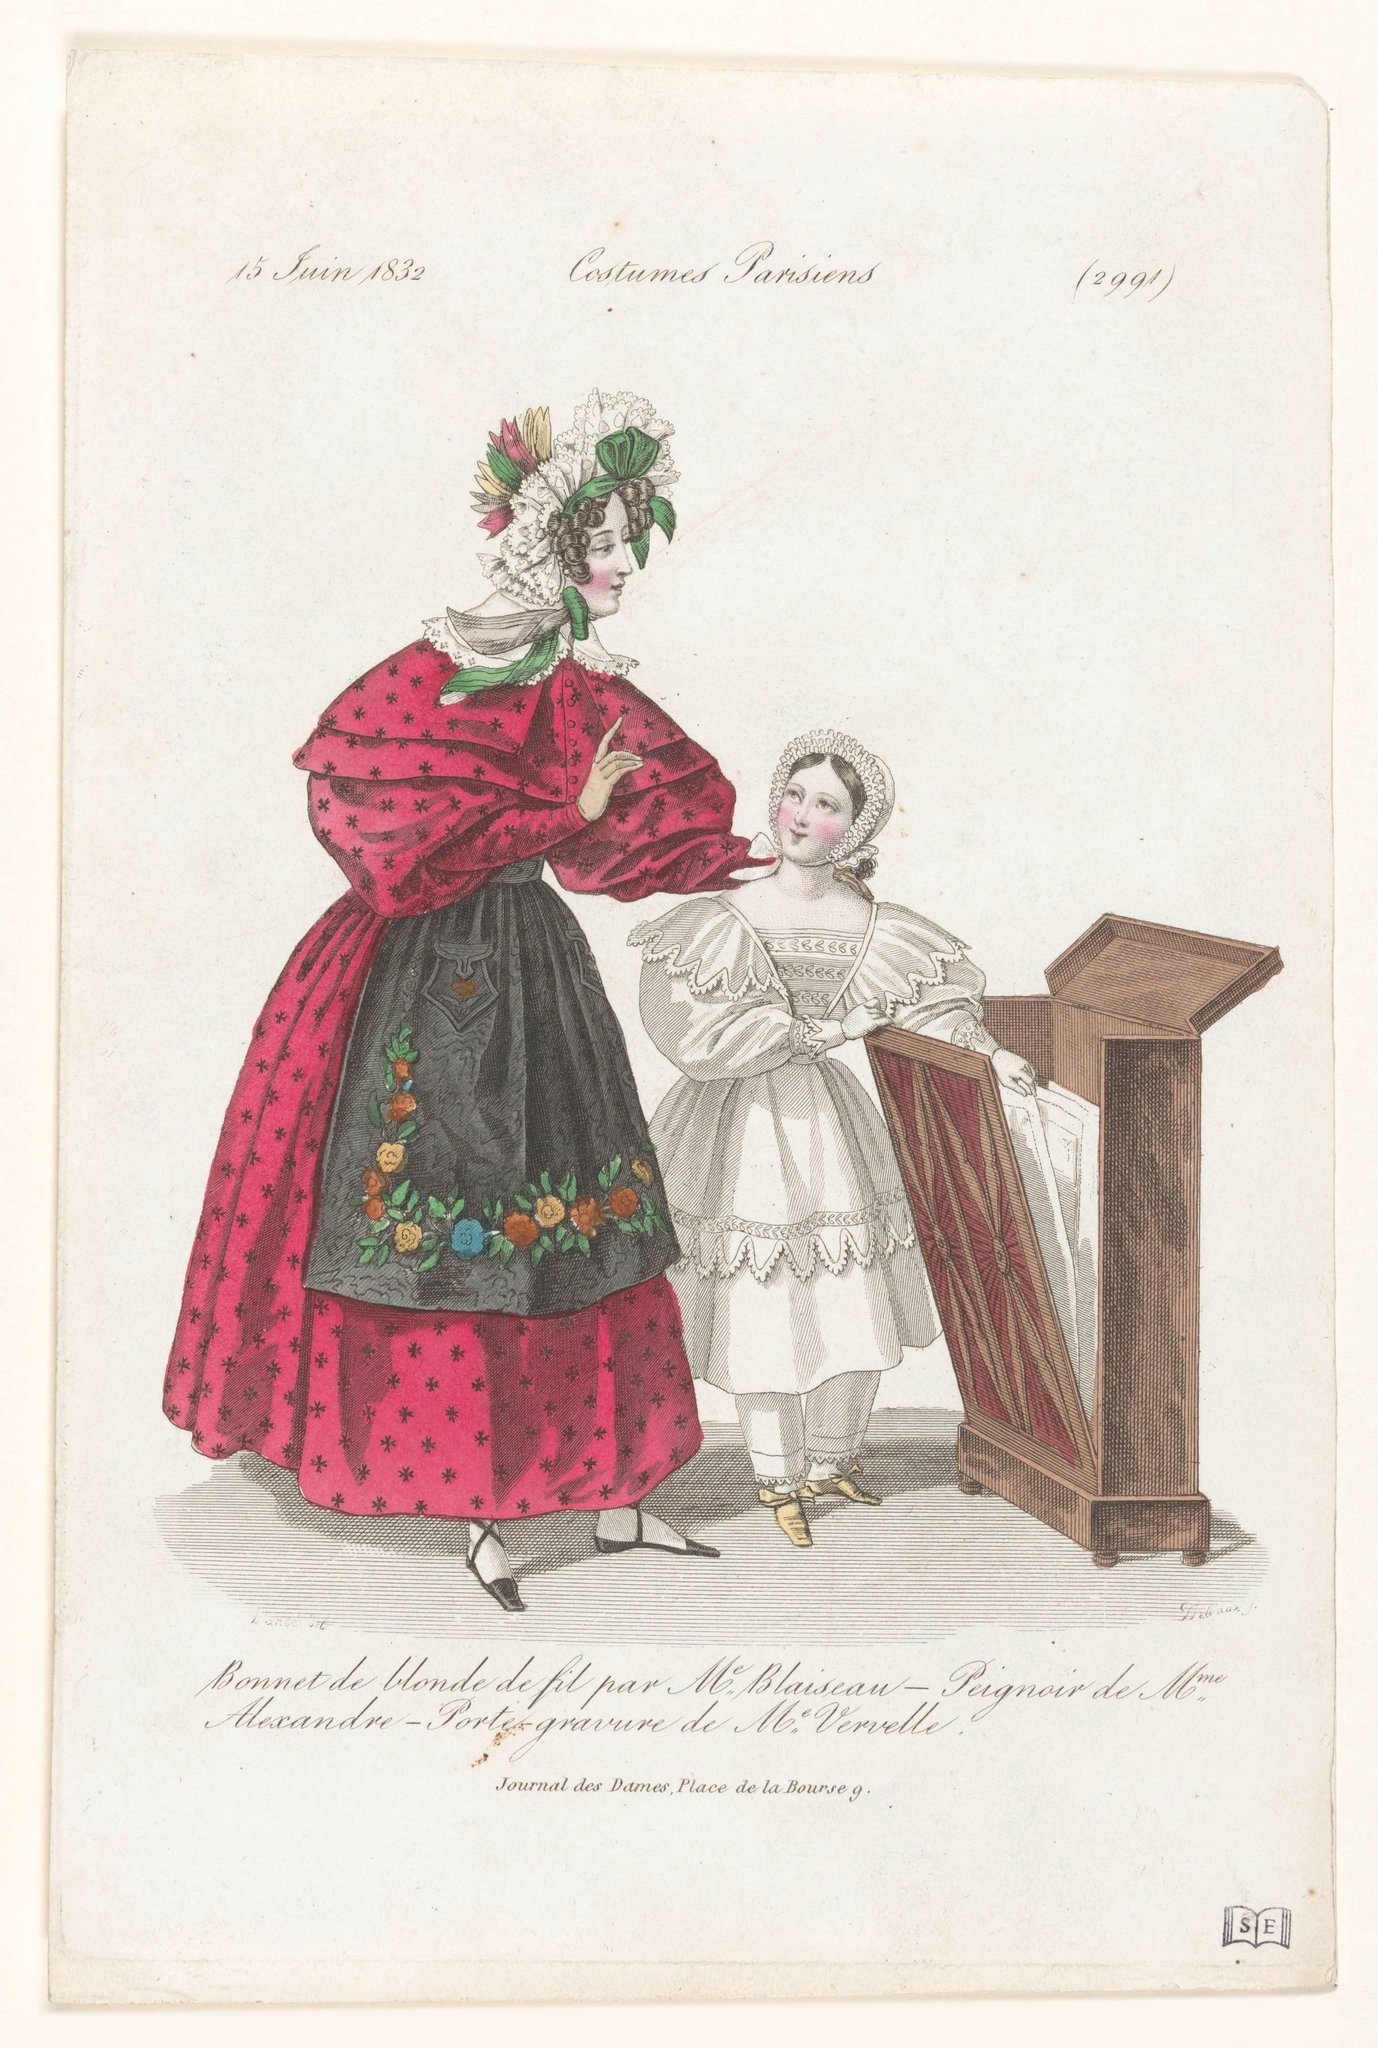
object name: fashion print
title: Een vrouw en een meisje naast een meubel met prenten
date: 1806-1832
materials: paper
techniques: etching, hand coloring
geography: paris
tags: print, e.g.: engraving, etching, lithograph, fashion plates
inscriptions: collector's mark: Lugt 2228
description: Prent uit het modetijdschrift La Mode (1829-1855).